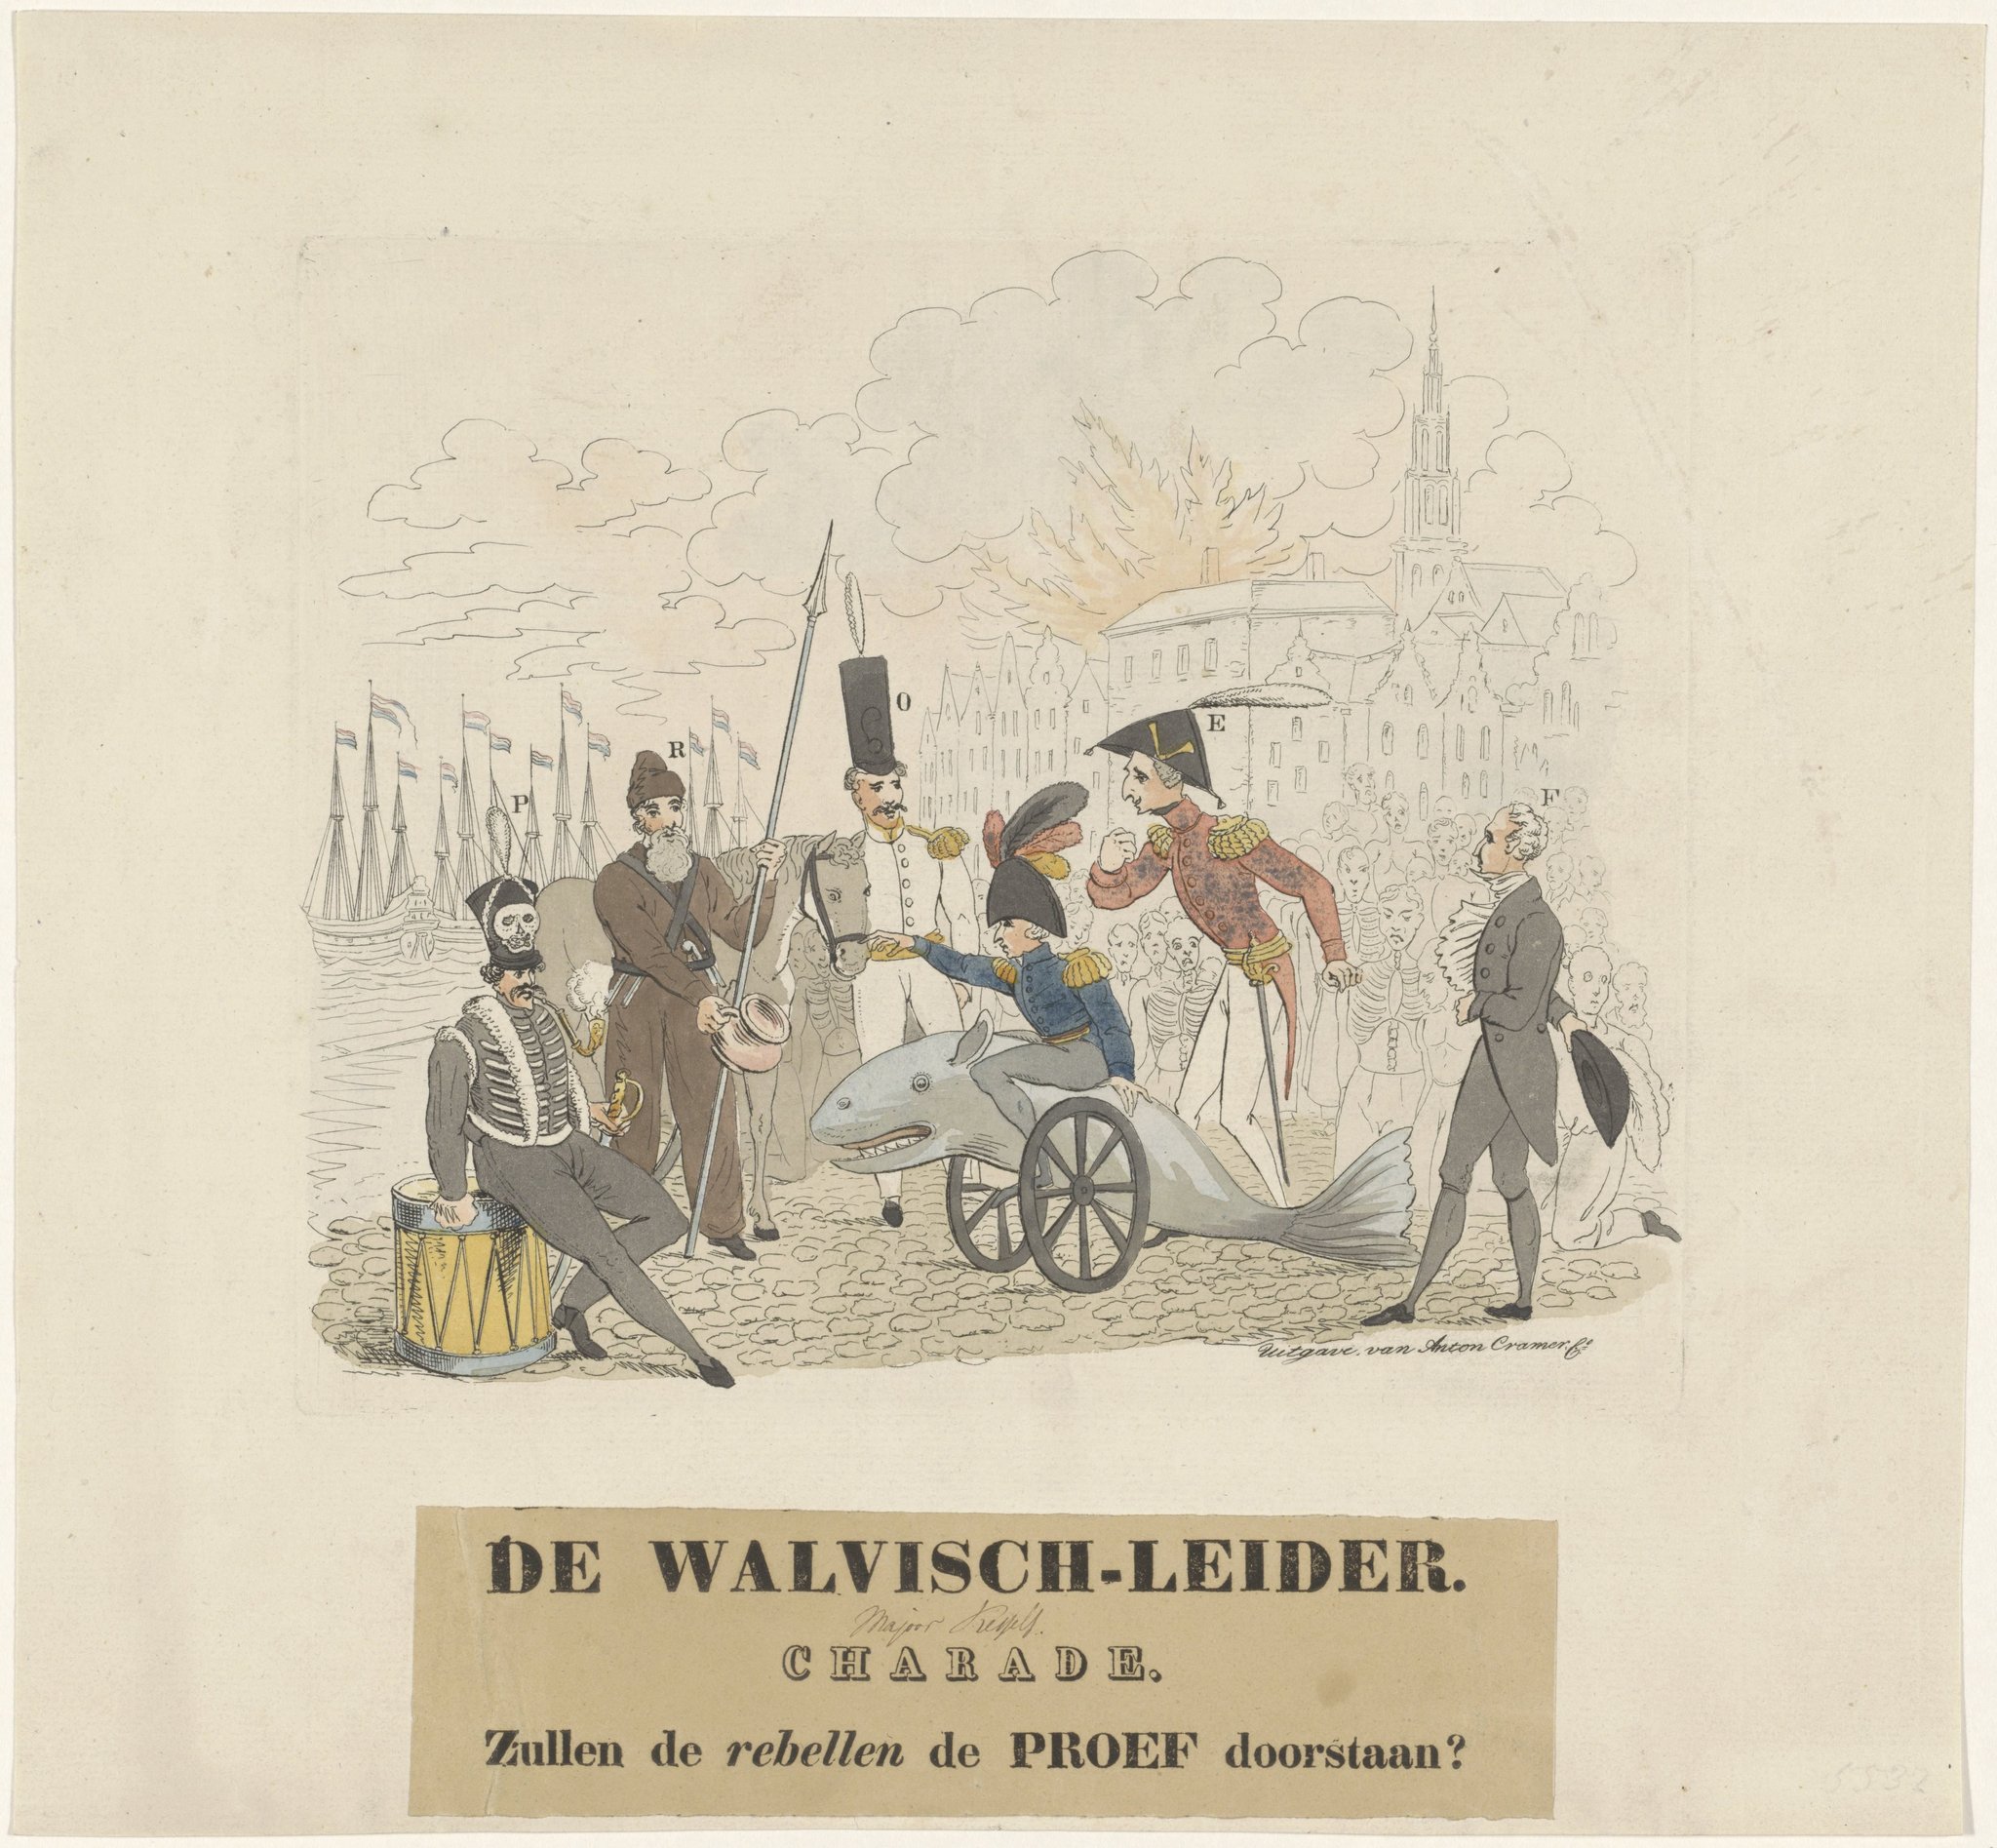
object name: print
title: Spotprent op Kessels, 1830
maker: Anonymous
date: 1830-1831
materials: paper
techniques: etching, hand coloring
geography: netherlands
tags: herman kessels, antwerp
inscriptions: collector's mark: Lugt 2228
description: Spotprent op generaal Herman Kessels, gezeten op een walvis op wielen, 1830. Samen met een Pruis (P), een Russische kozak (R), een Oostenrijker (O), een Engelsman (E) en een Fransman (F) op de kade terwijl op de achtergrond de bevolking verhongert en de stad Antwerpen in brand wordt geschoten door Nederlandse schepen (27 oktober 1830). Zie ook de pendant.